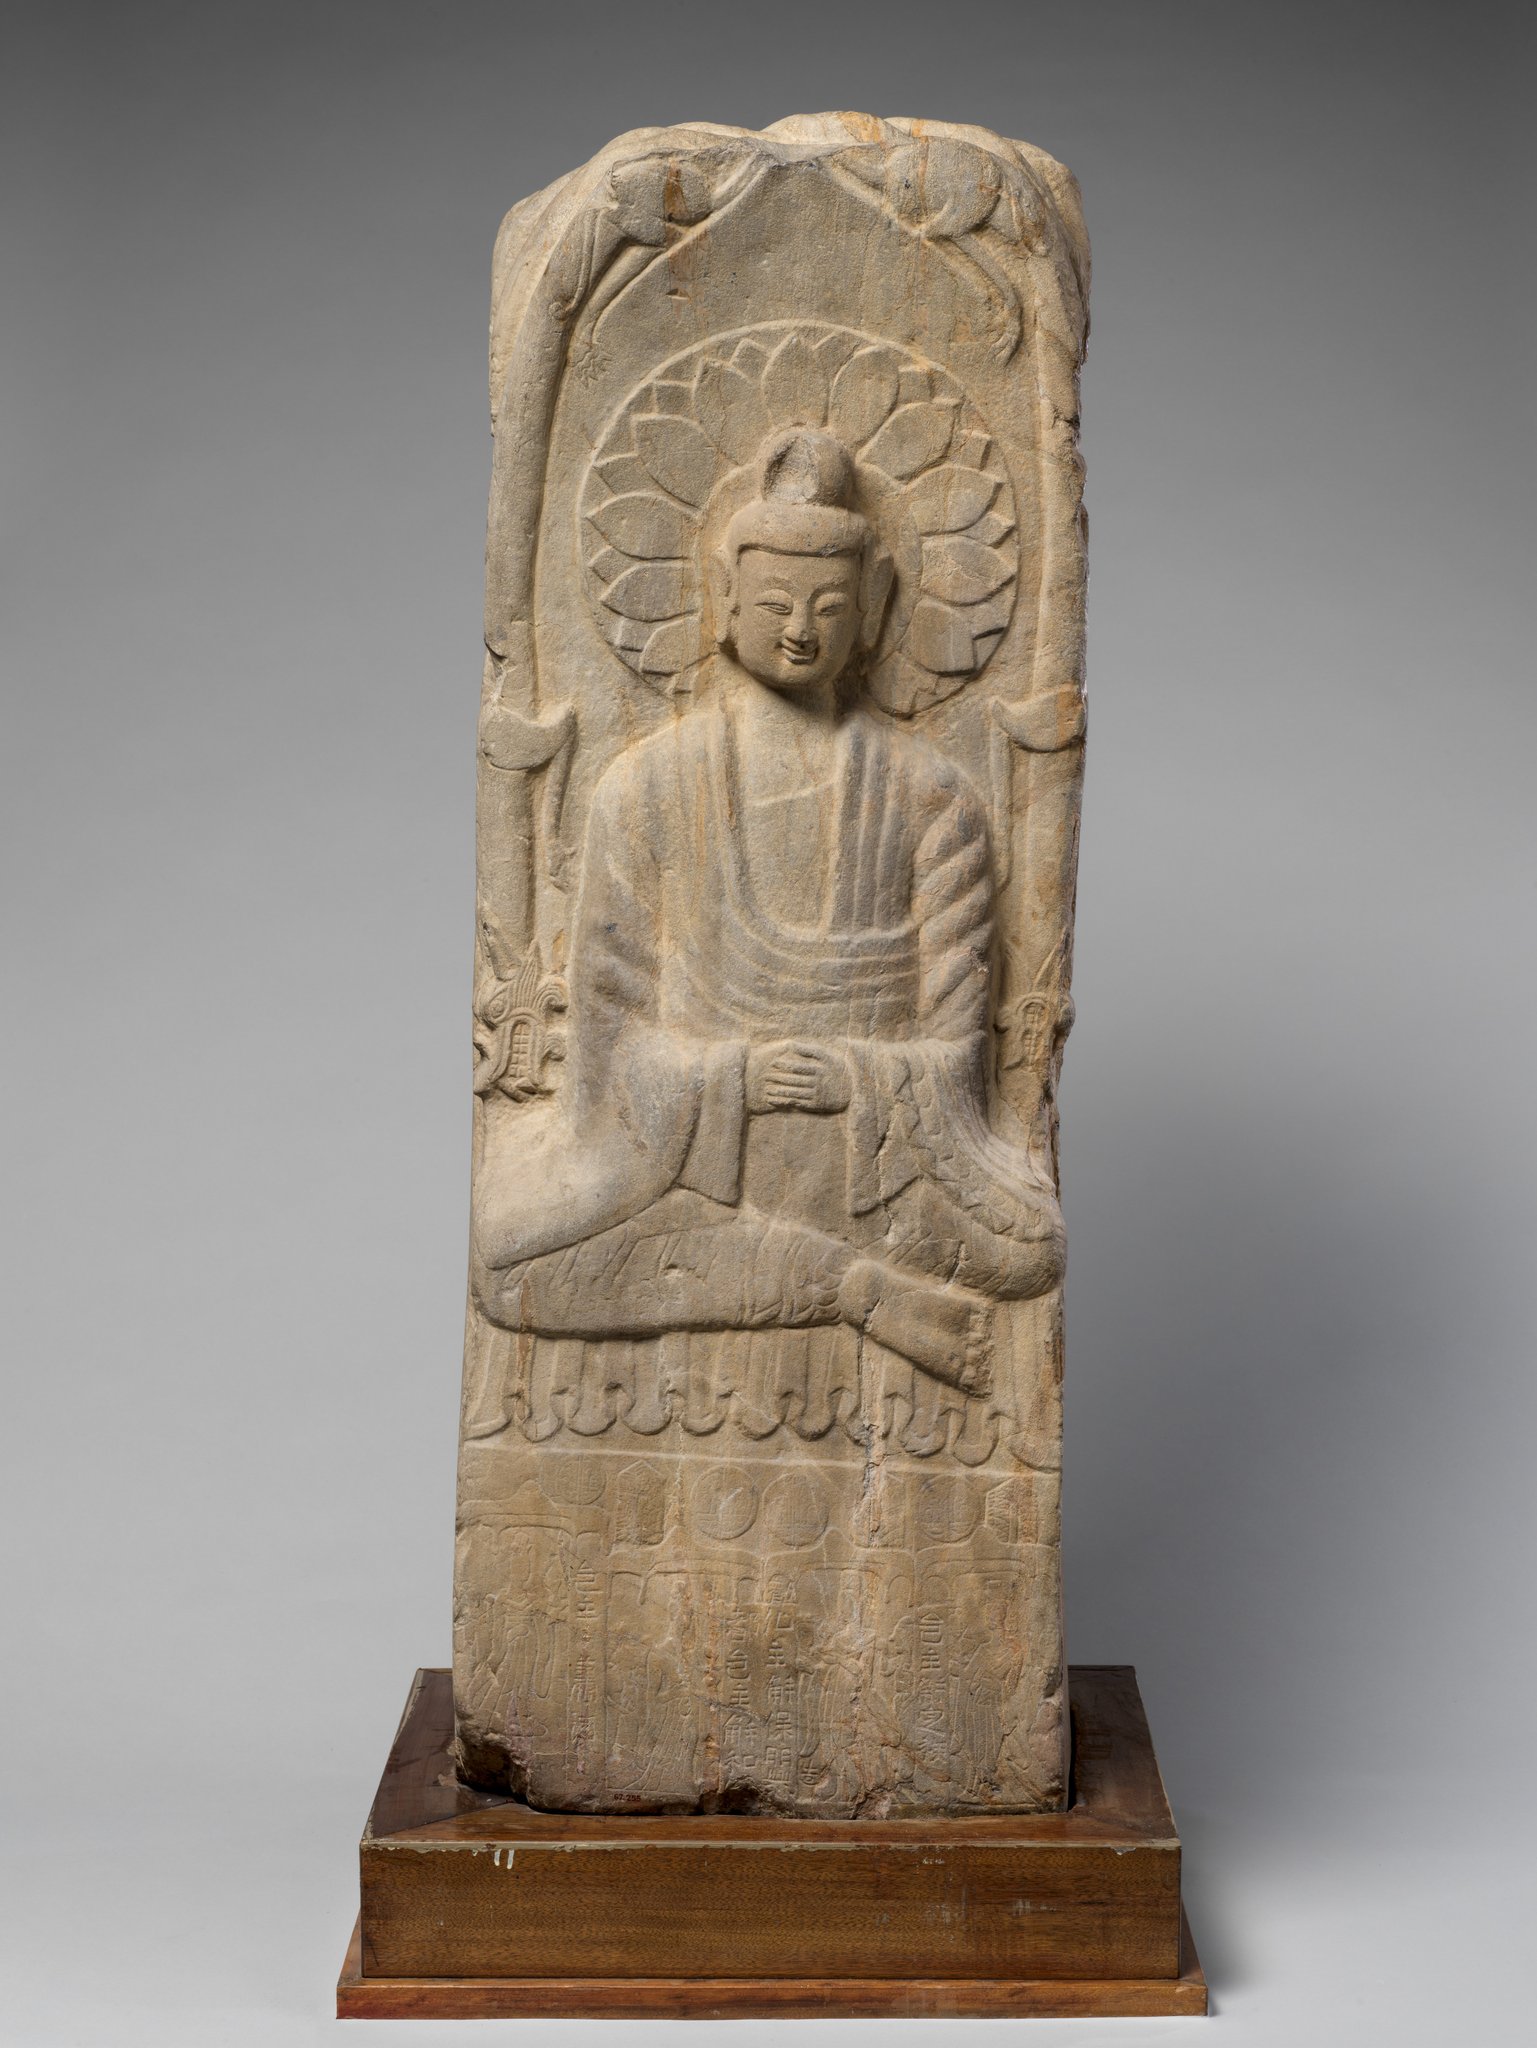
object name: stele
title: Stele with Buddha Maitreya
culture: chinese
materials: limestone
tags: buddhism,buddha,maitreya